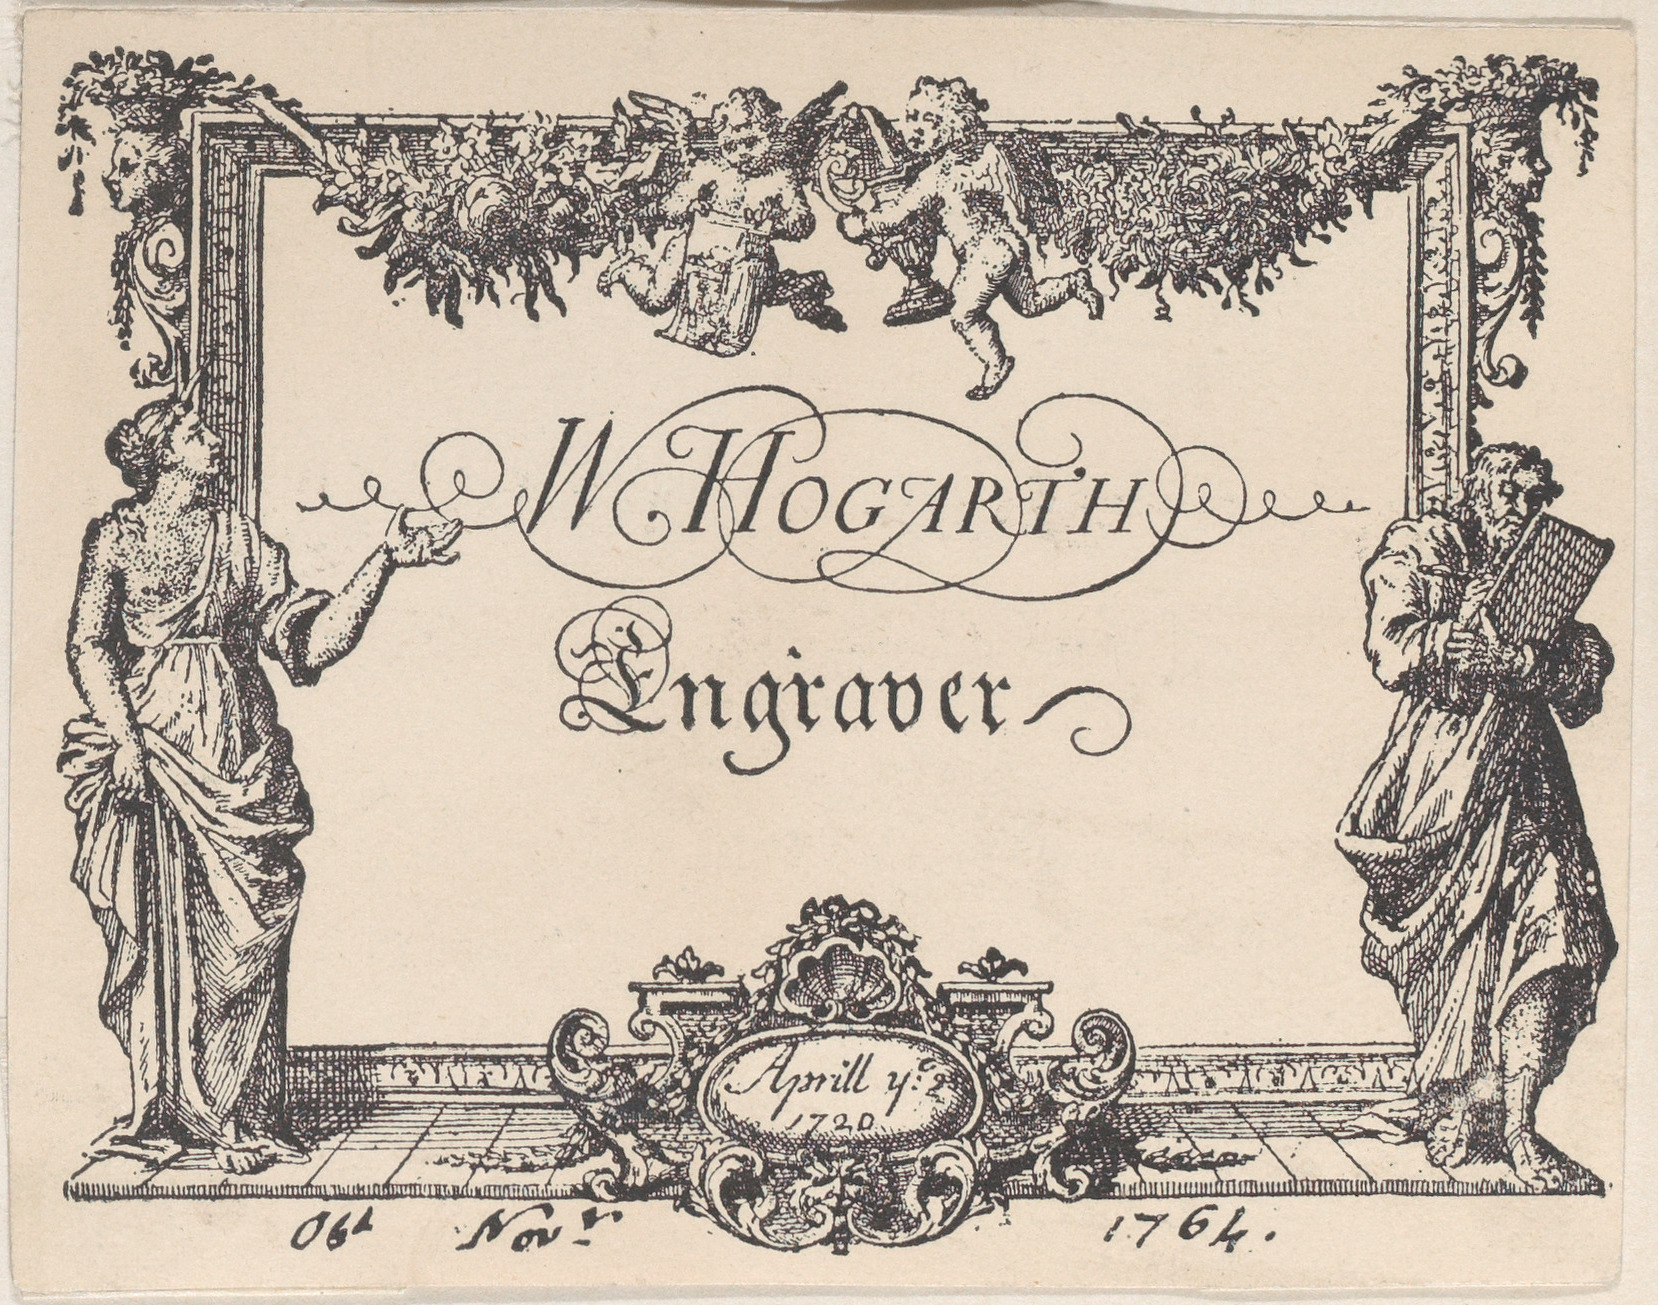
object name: print, trade card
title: William Hogarth's Trade Card (modern reproduction)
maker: william hogarth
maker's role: artist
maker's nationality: british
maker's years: 1697-1764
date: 1880-1928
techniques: engraving, etching, lithograph